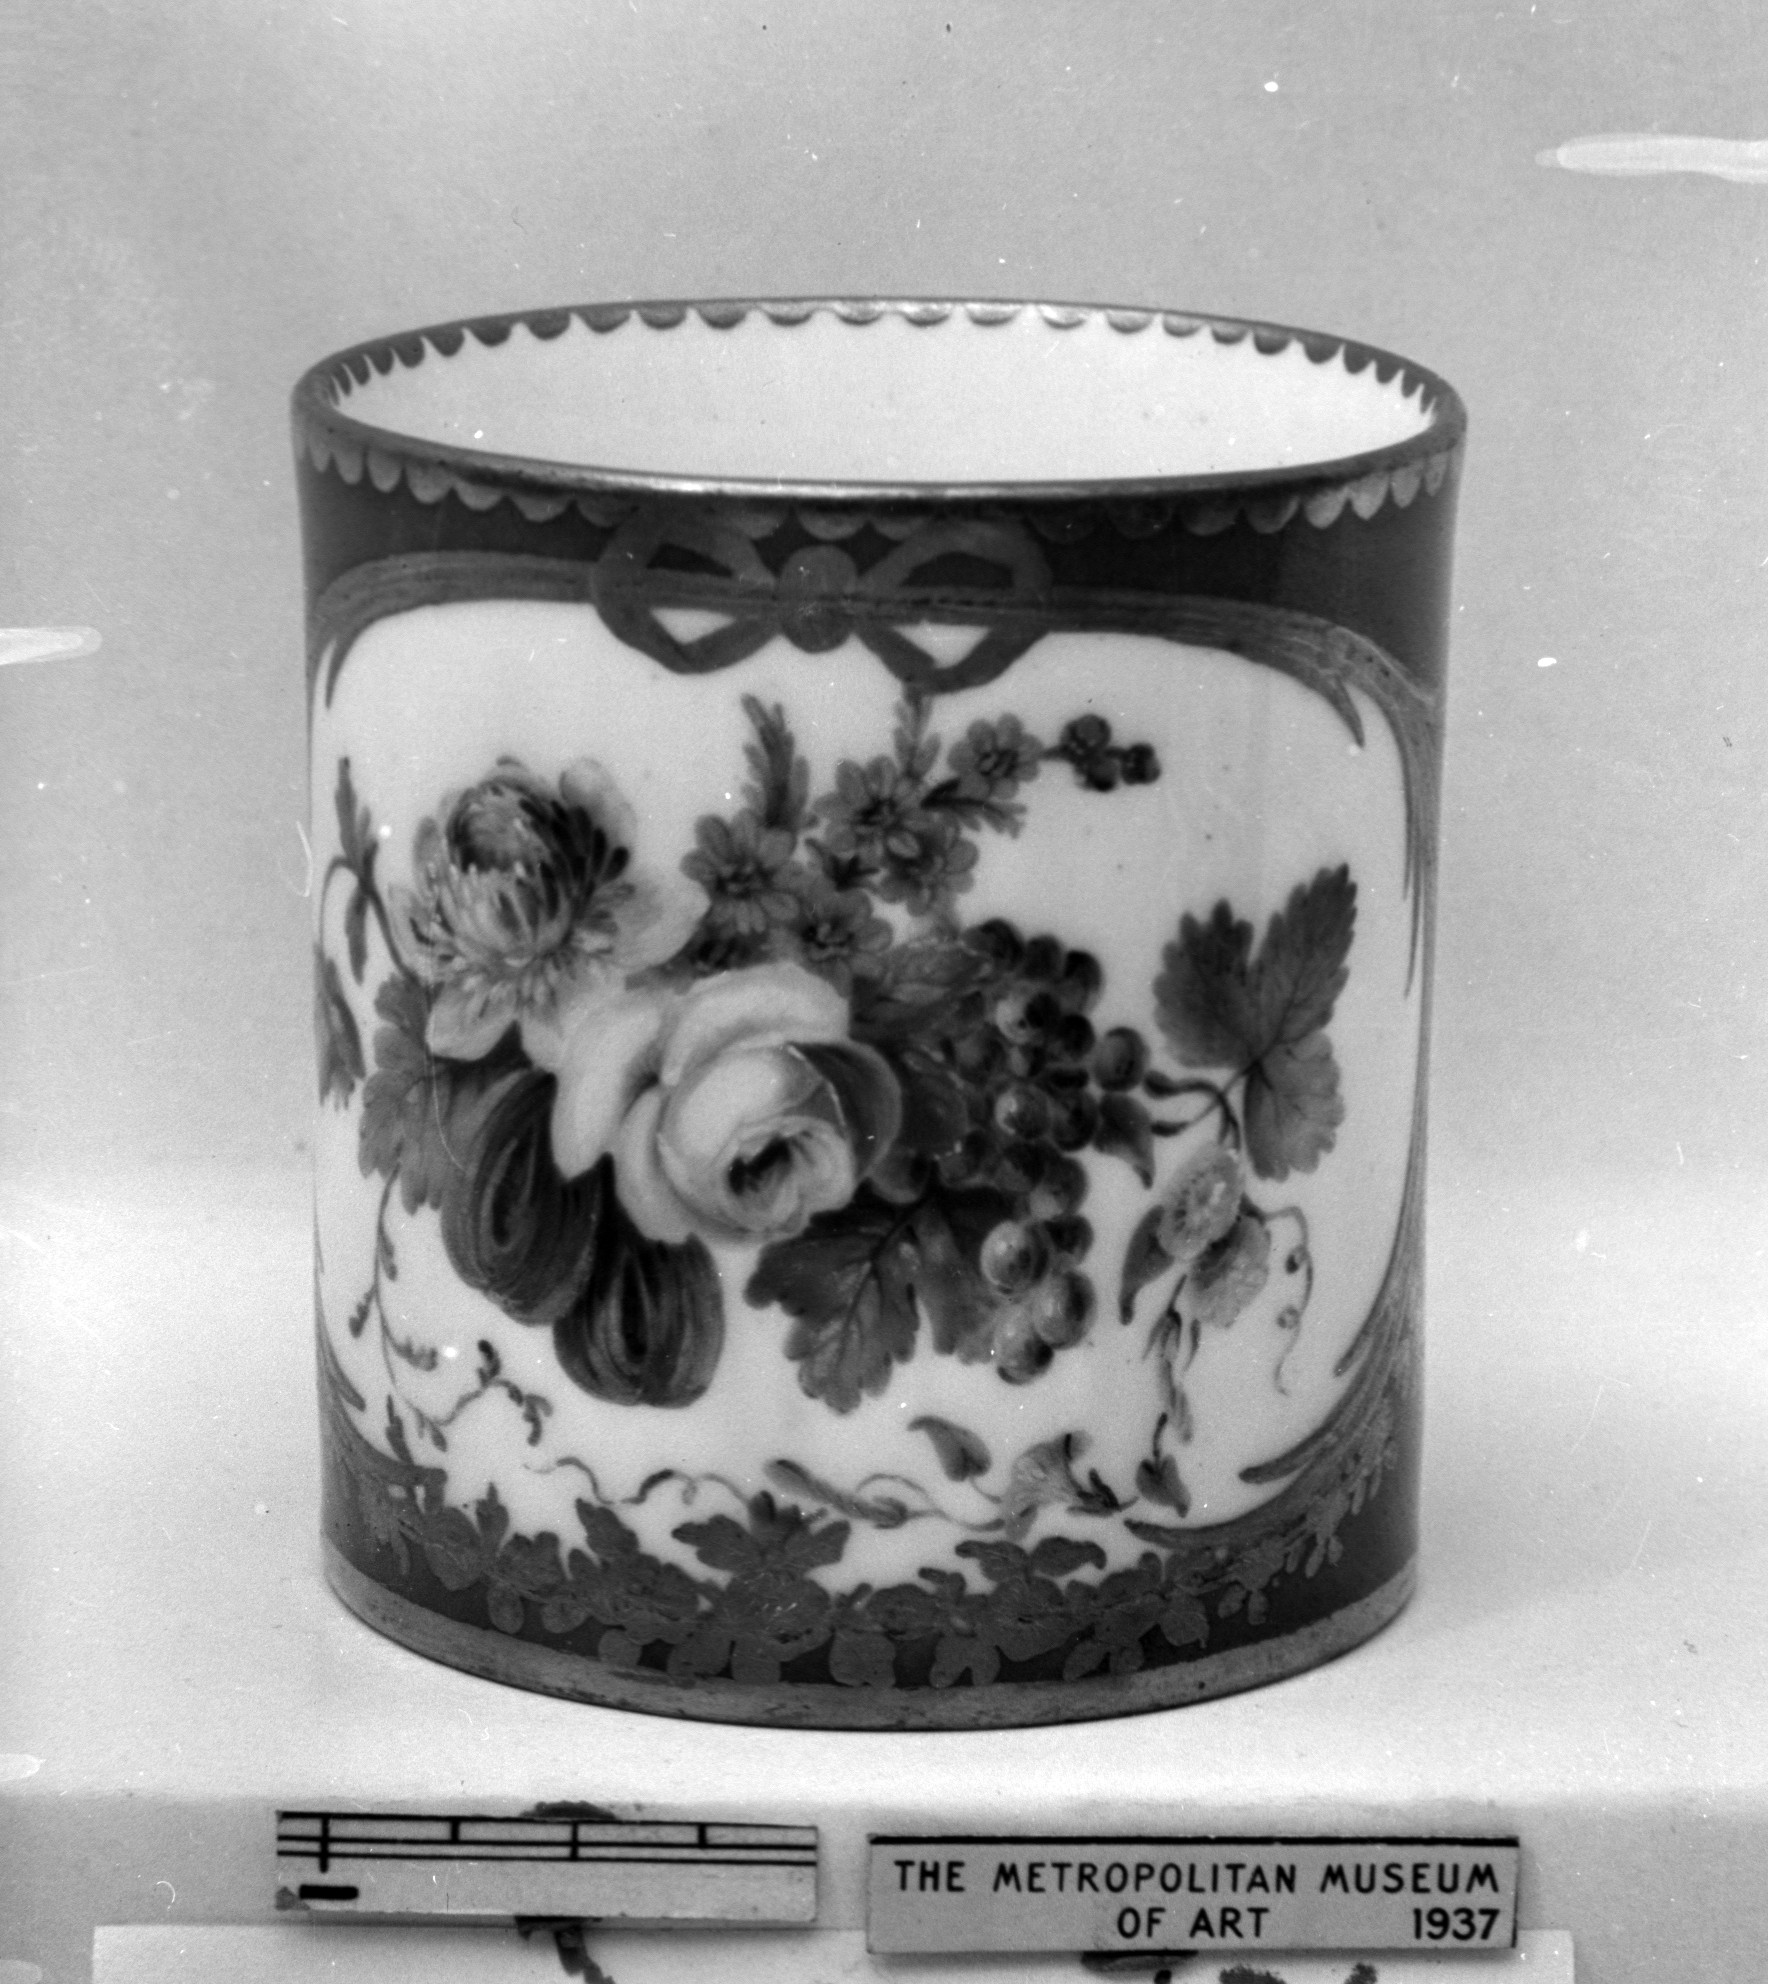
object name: cup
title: Cup (Gobelet litron) (one of nine) (part of a a service)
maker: sèvres manufactory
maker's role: manufactory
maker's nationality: french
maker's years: 1740-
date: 1787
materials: soft paste porcelain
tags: grapes,flowers